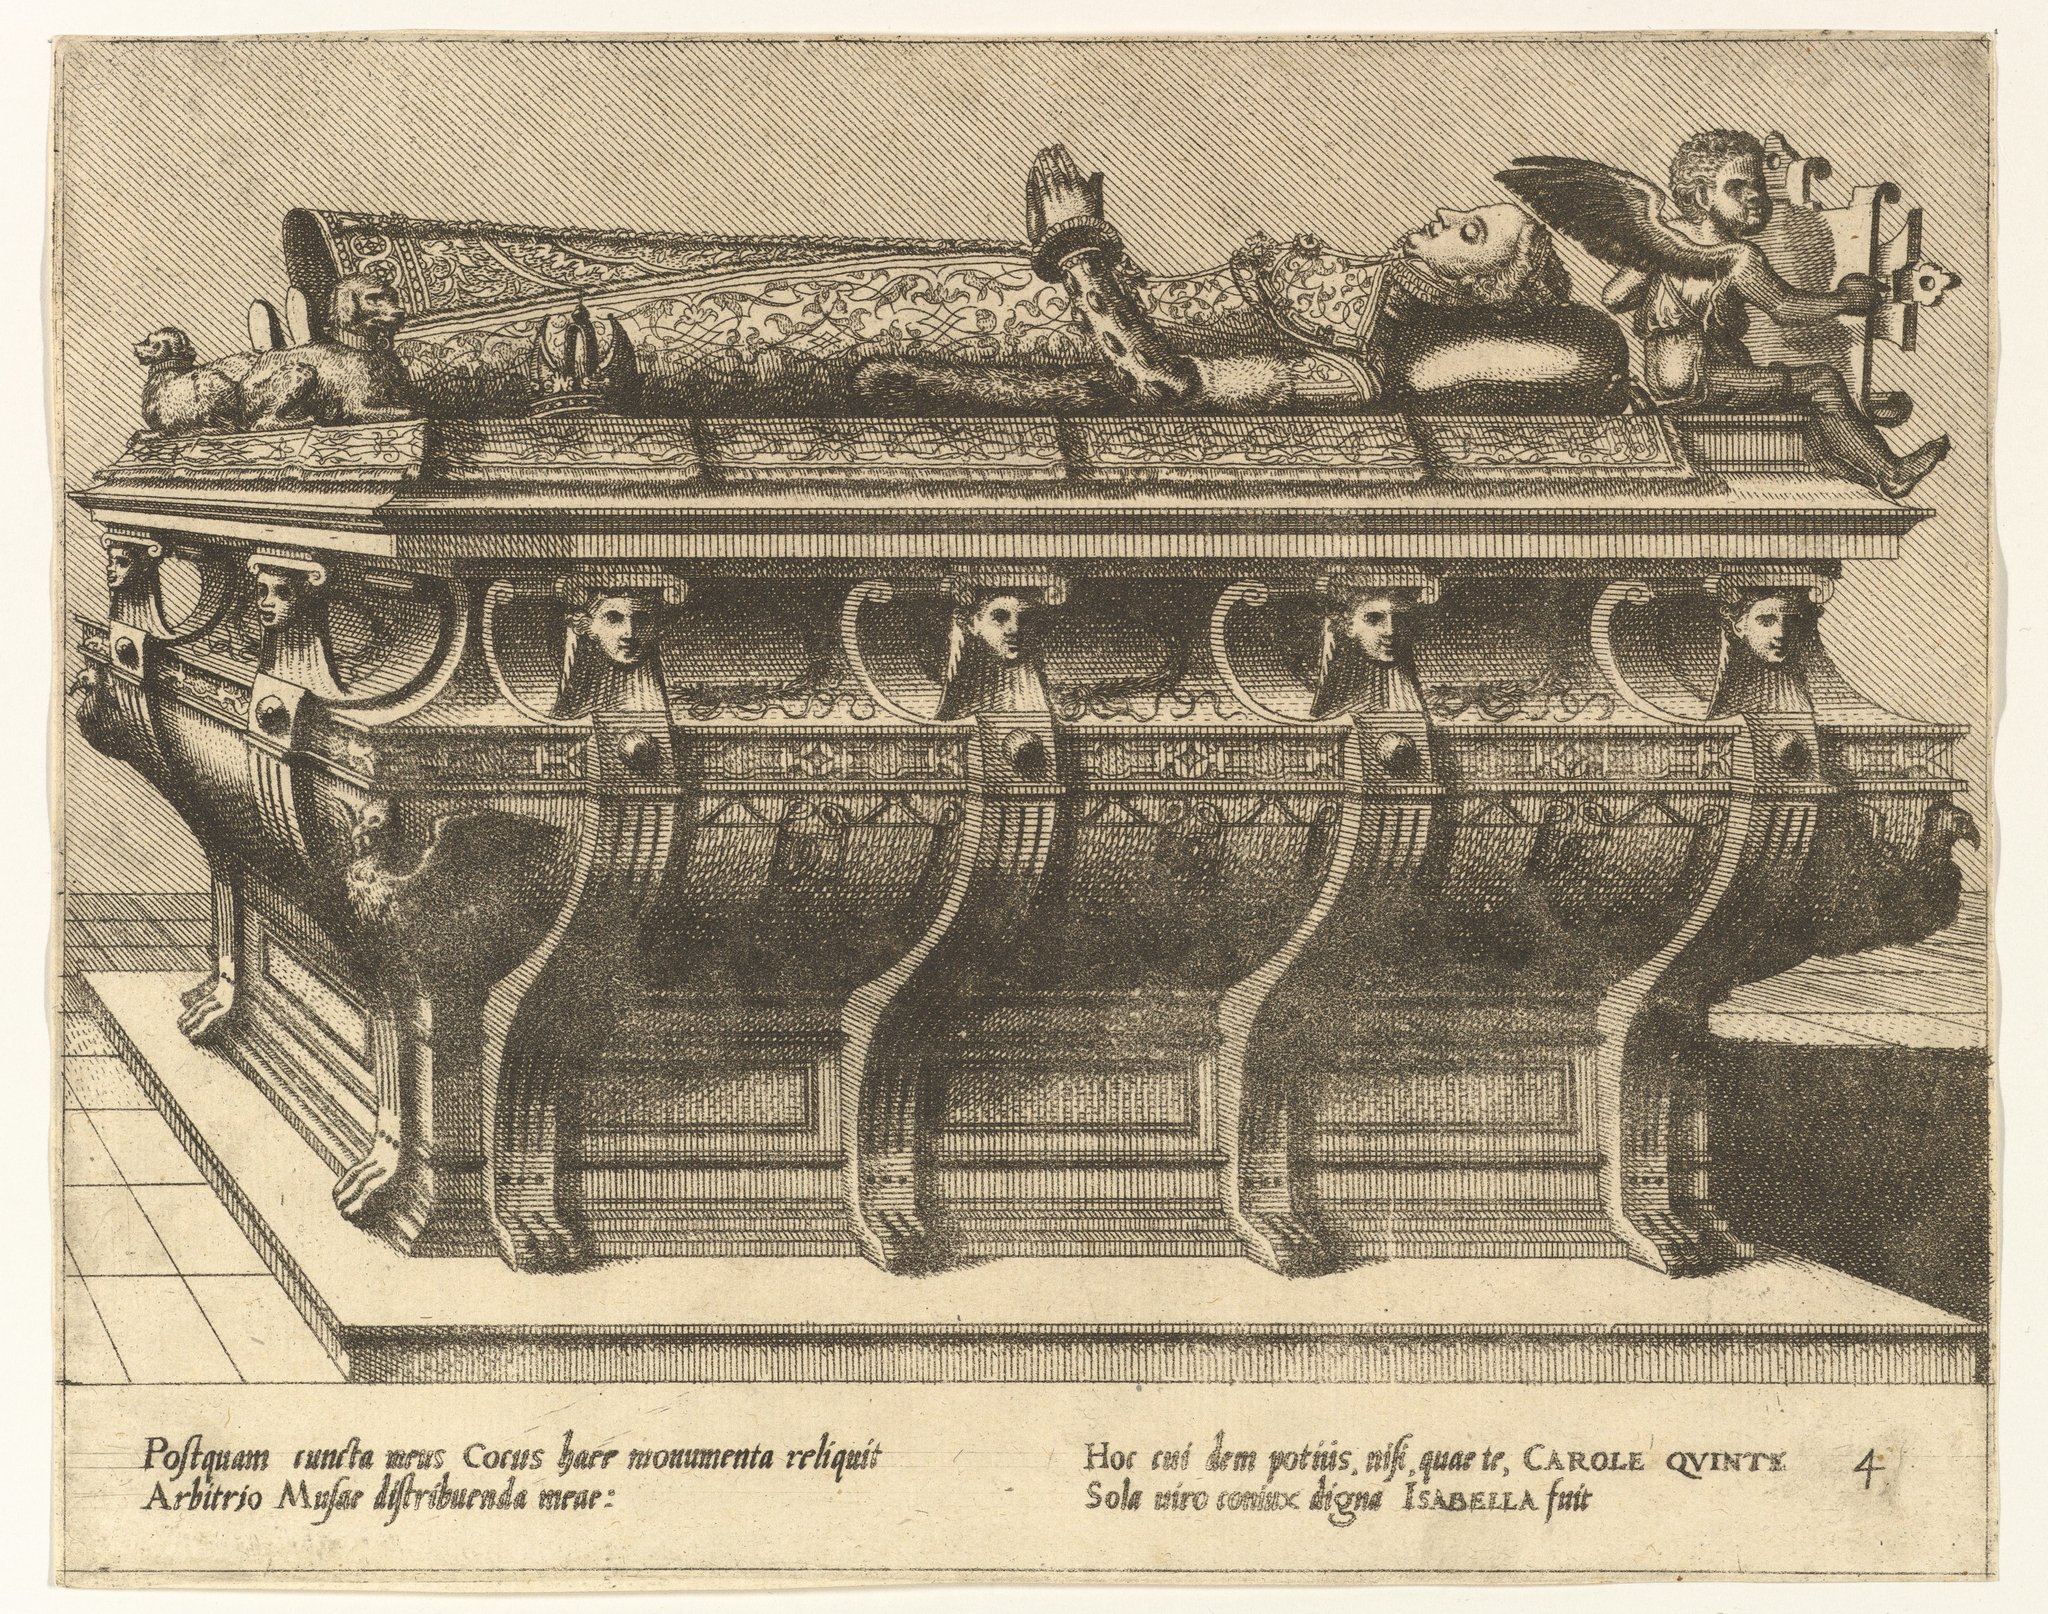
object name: collection ornament architecture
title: Cœnotaphiorum (4)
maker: hans vredeman de vries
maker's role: artist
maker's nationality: netherlandish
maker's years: 1527-1606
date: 1563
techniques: etching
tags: tombs,faces,women,dogs